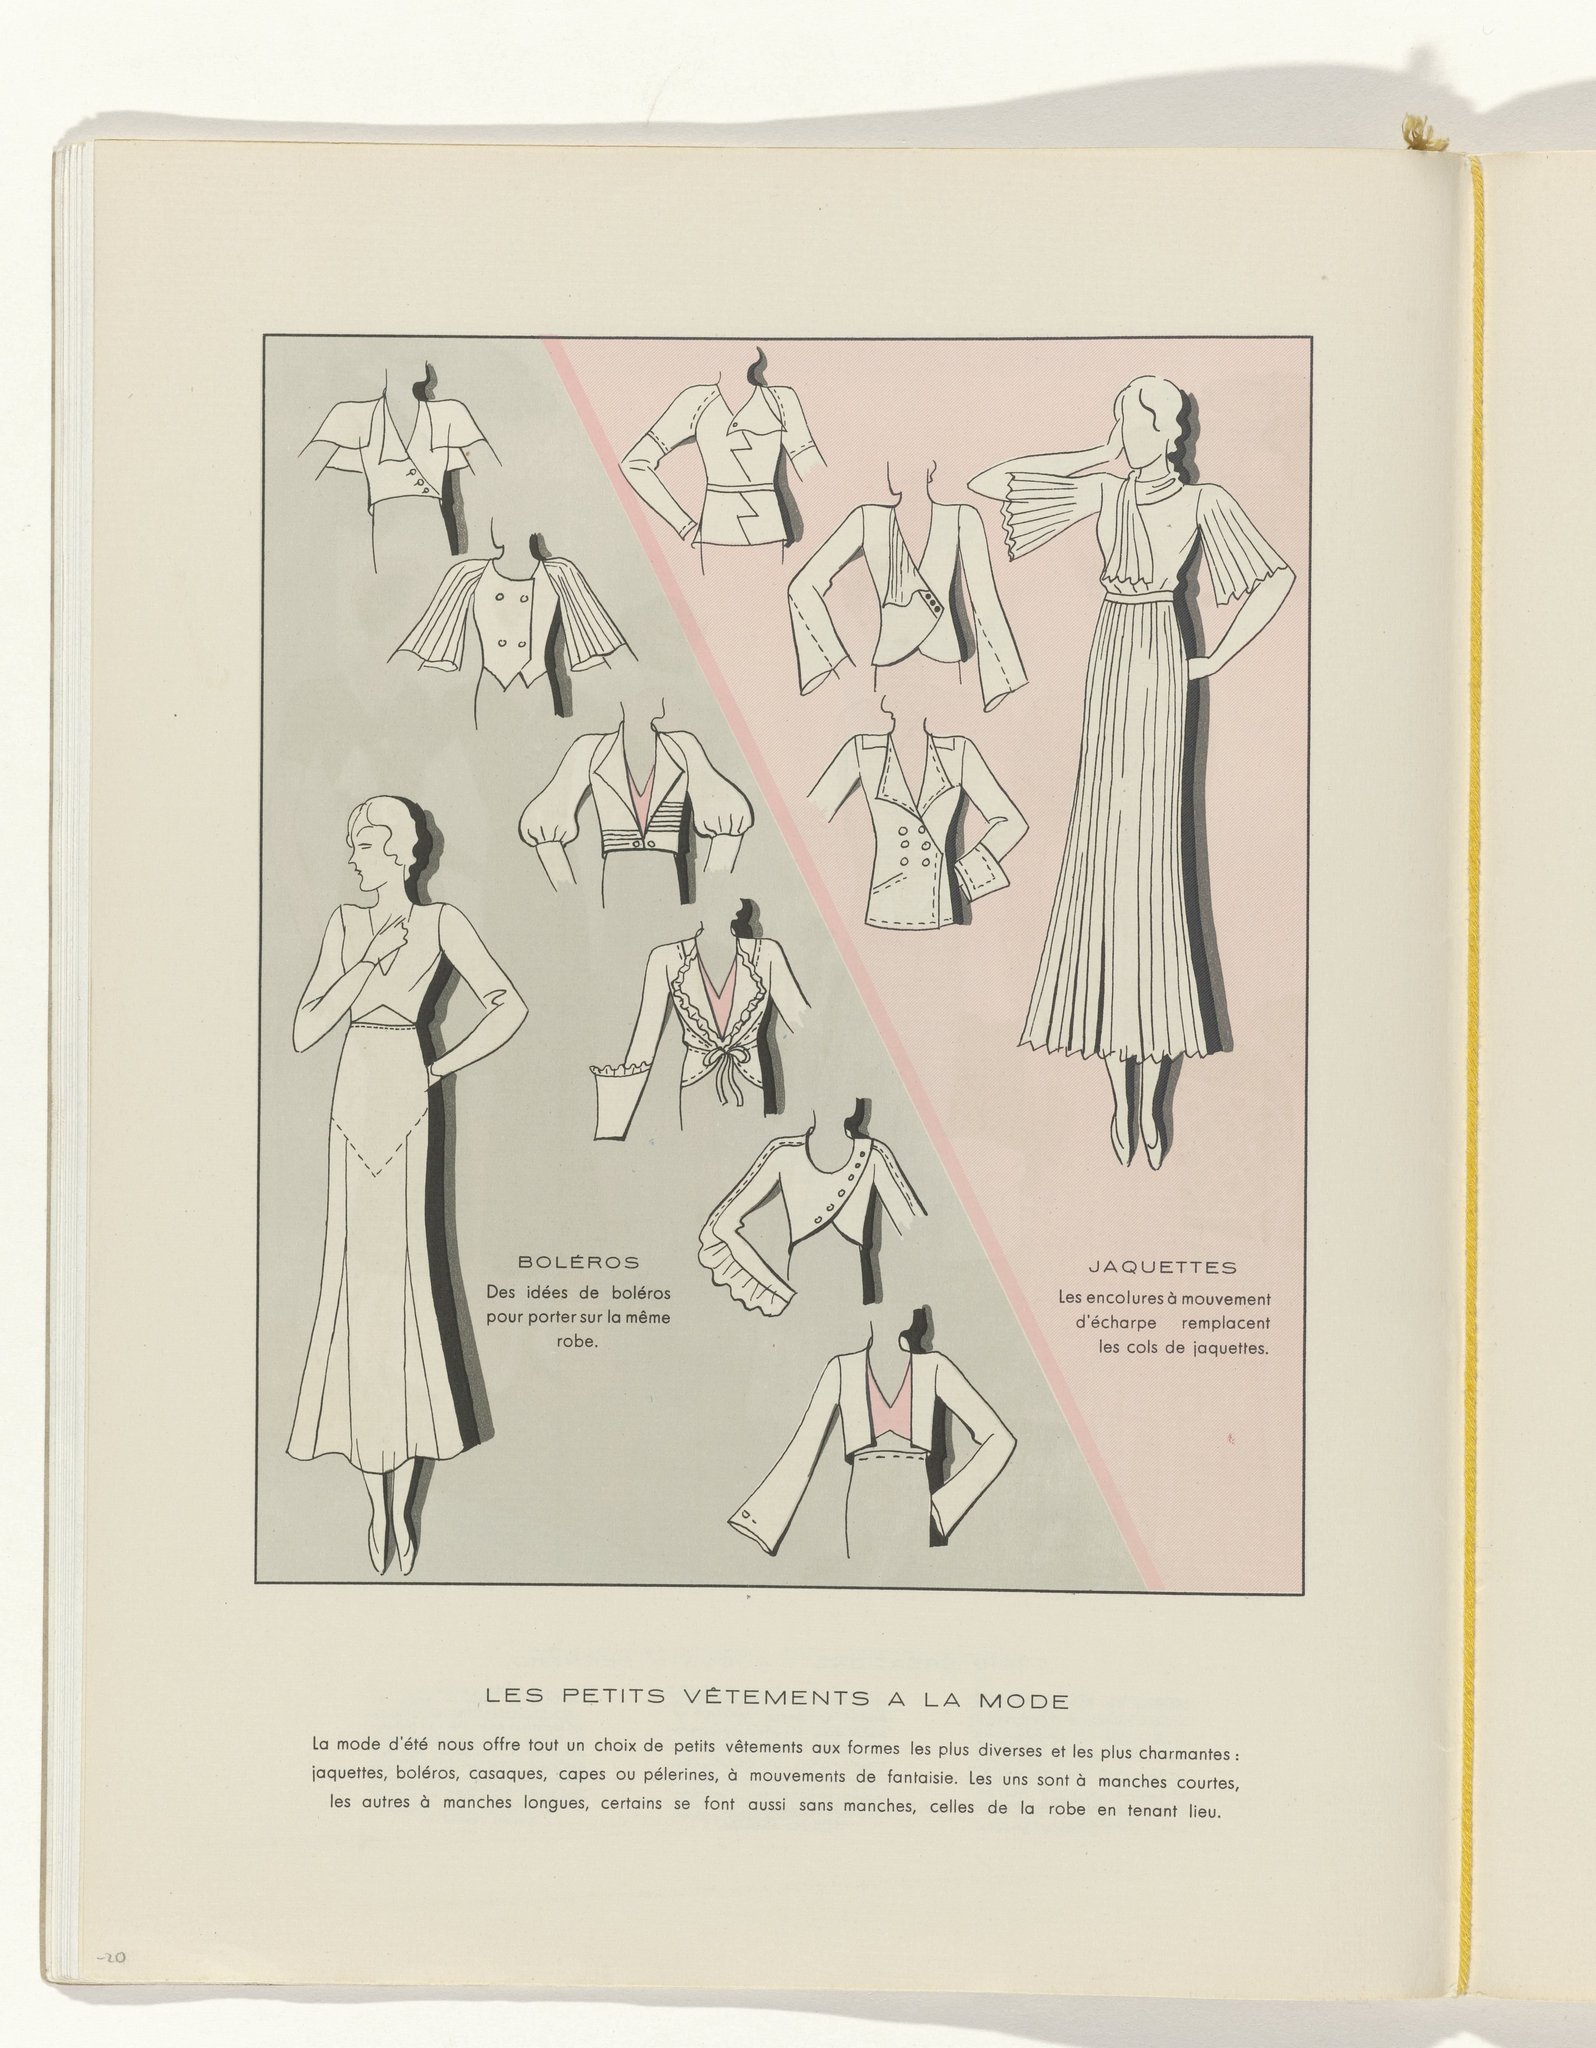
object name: magazine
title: Art - Goût - Beauté, Feuillets de l' élégance féminine, Juin 1932, No. 142, 12e Année, p. 20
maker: henri rouit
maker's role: publisher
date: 1932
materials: paper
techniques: hand coloring, lithograph, pochoir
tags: coat (+ women's clothes), clothing for the upper part of the body (bolero) (+ women's clothes), fashion plates, dress, gown (+ women's clothes)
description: 'Les petits vêtements a la mode'. Linksonder: zes verschillende bolero's om te dragen op dezelfde jurk. Rechtsboven: vrouw in een jurk met geplooide sjaal, mouwen en rok, waarnaast drie verschillende jassen. Pagina uit het modetijdschrift Art-Goût-Beauté (1920-1933).